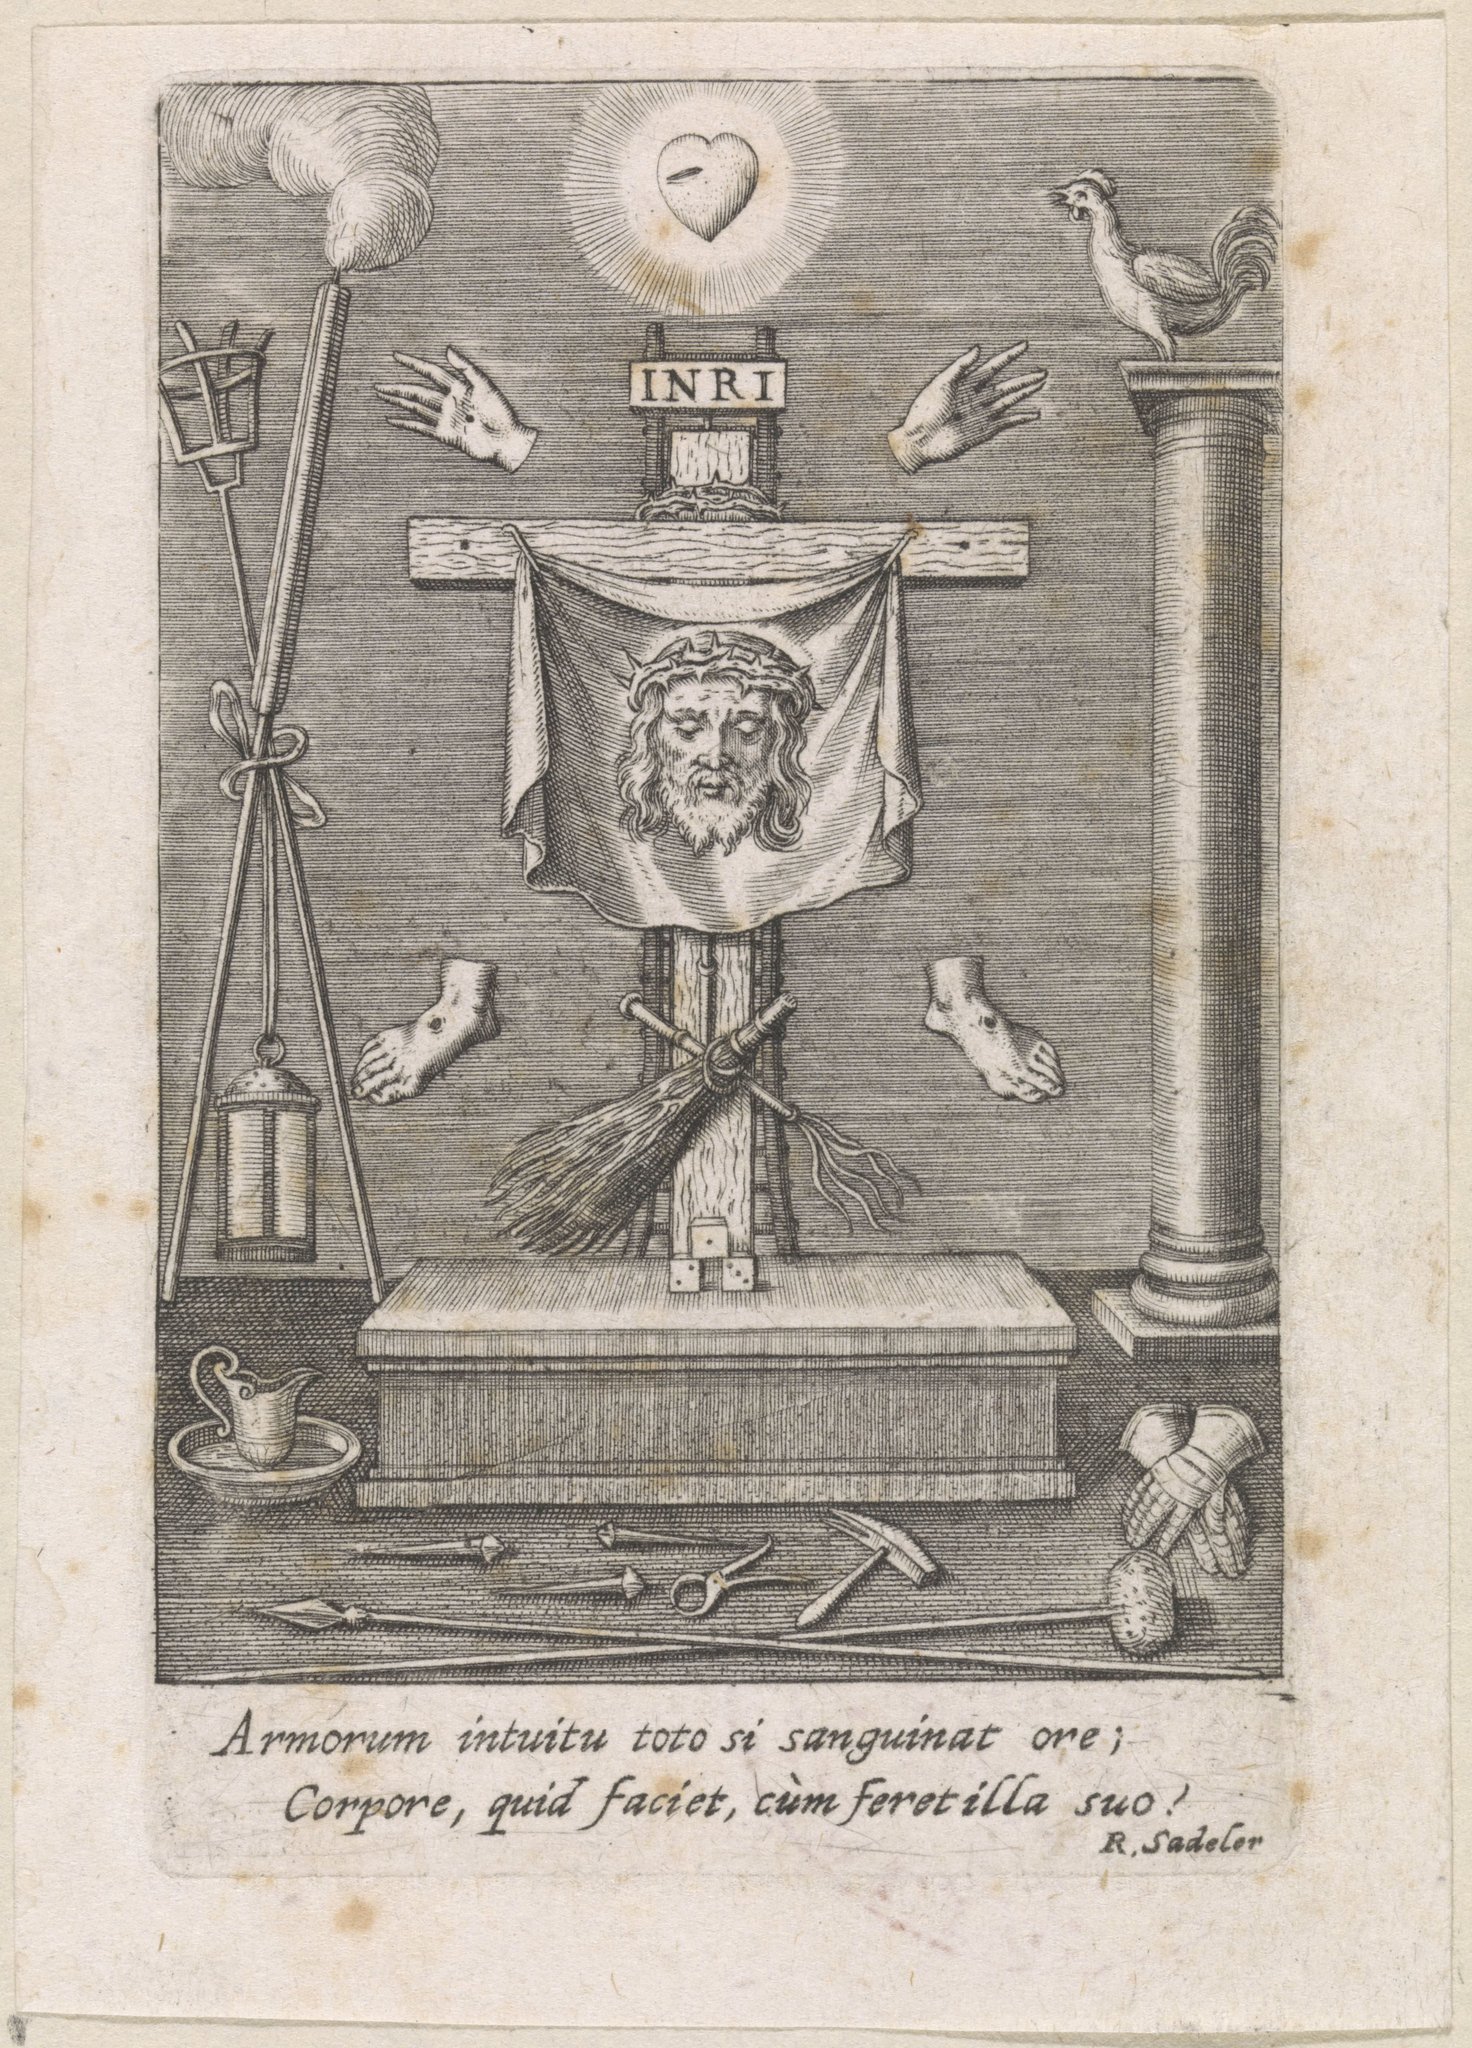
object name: book illustration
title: Passiewerktuigen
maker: anna bergia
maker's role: publisher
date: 1617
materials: paper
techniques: engraving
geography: munich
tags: single instruments of the passion, devotion ~ christ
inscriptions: collector's mark: Lugt 240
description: Prent uit: Ceschi, Matia. Otium spirituale mellifluarum precationum. München: Anna Bergia en Raphaël Sadeler (I) of (II), 1617.